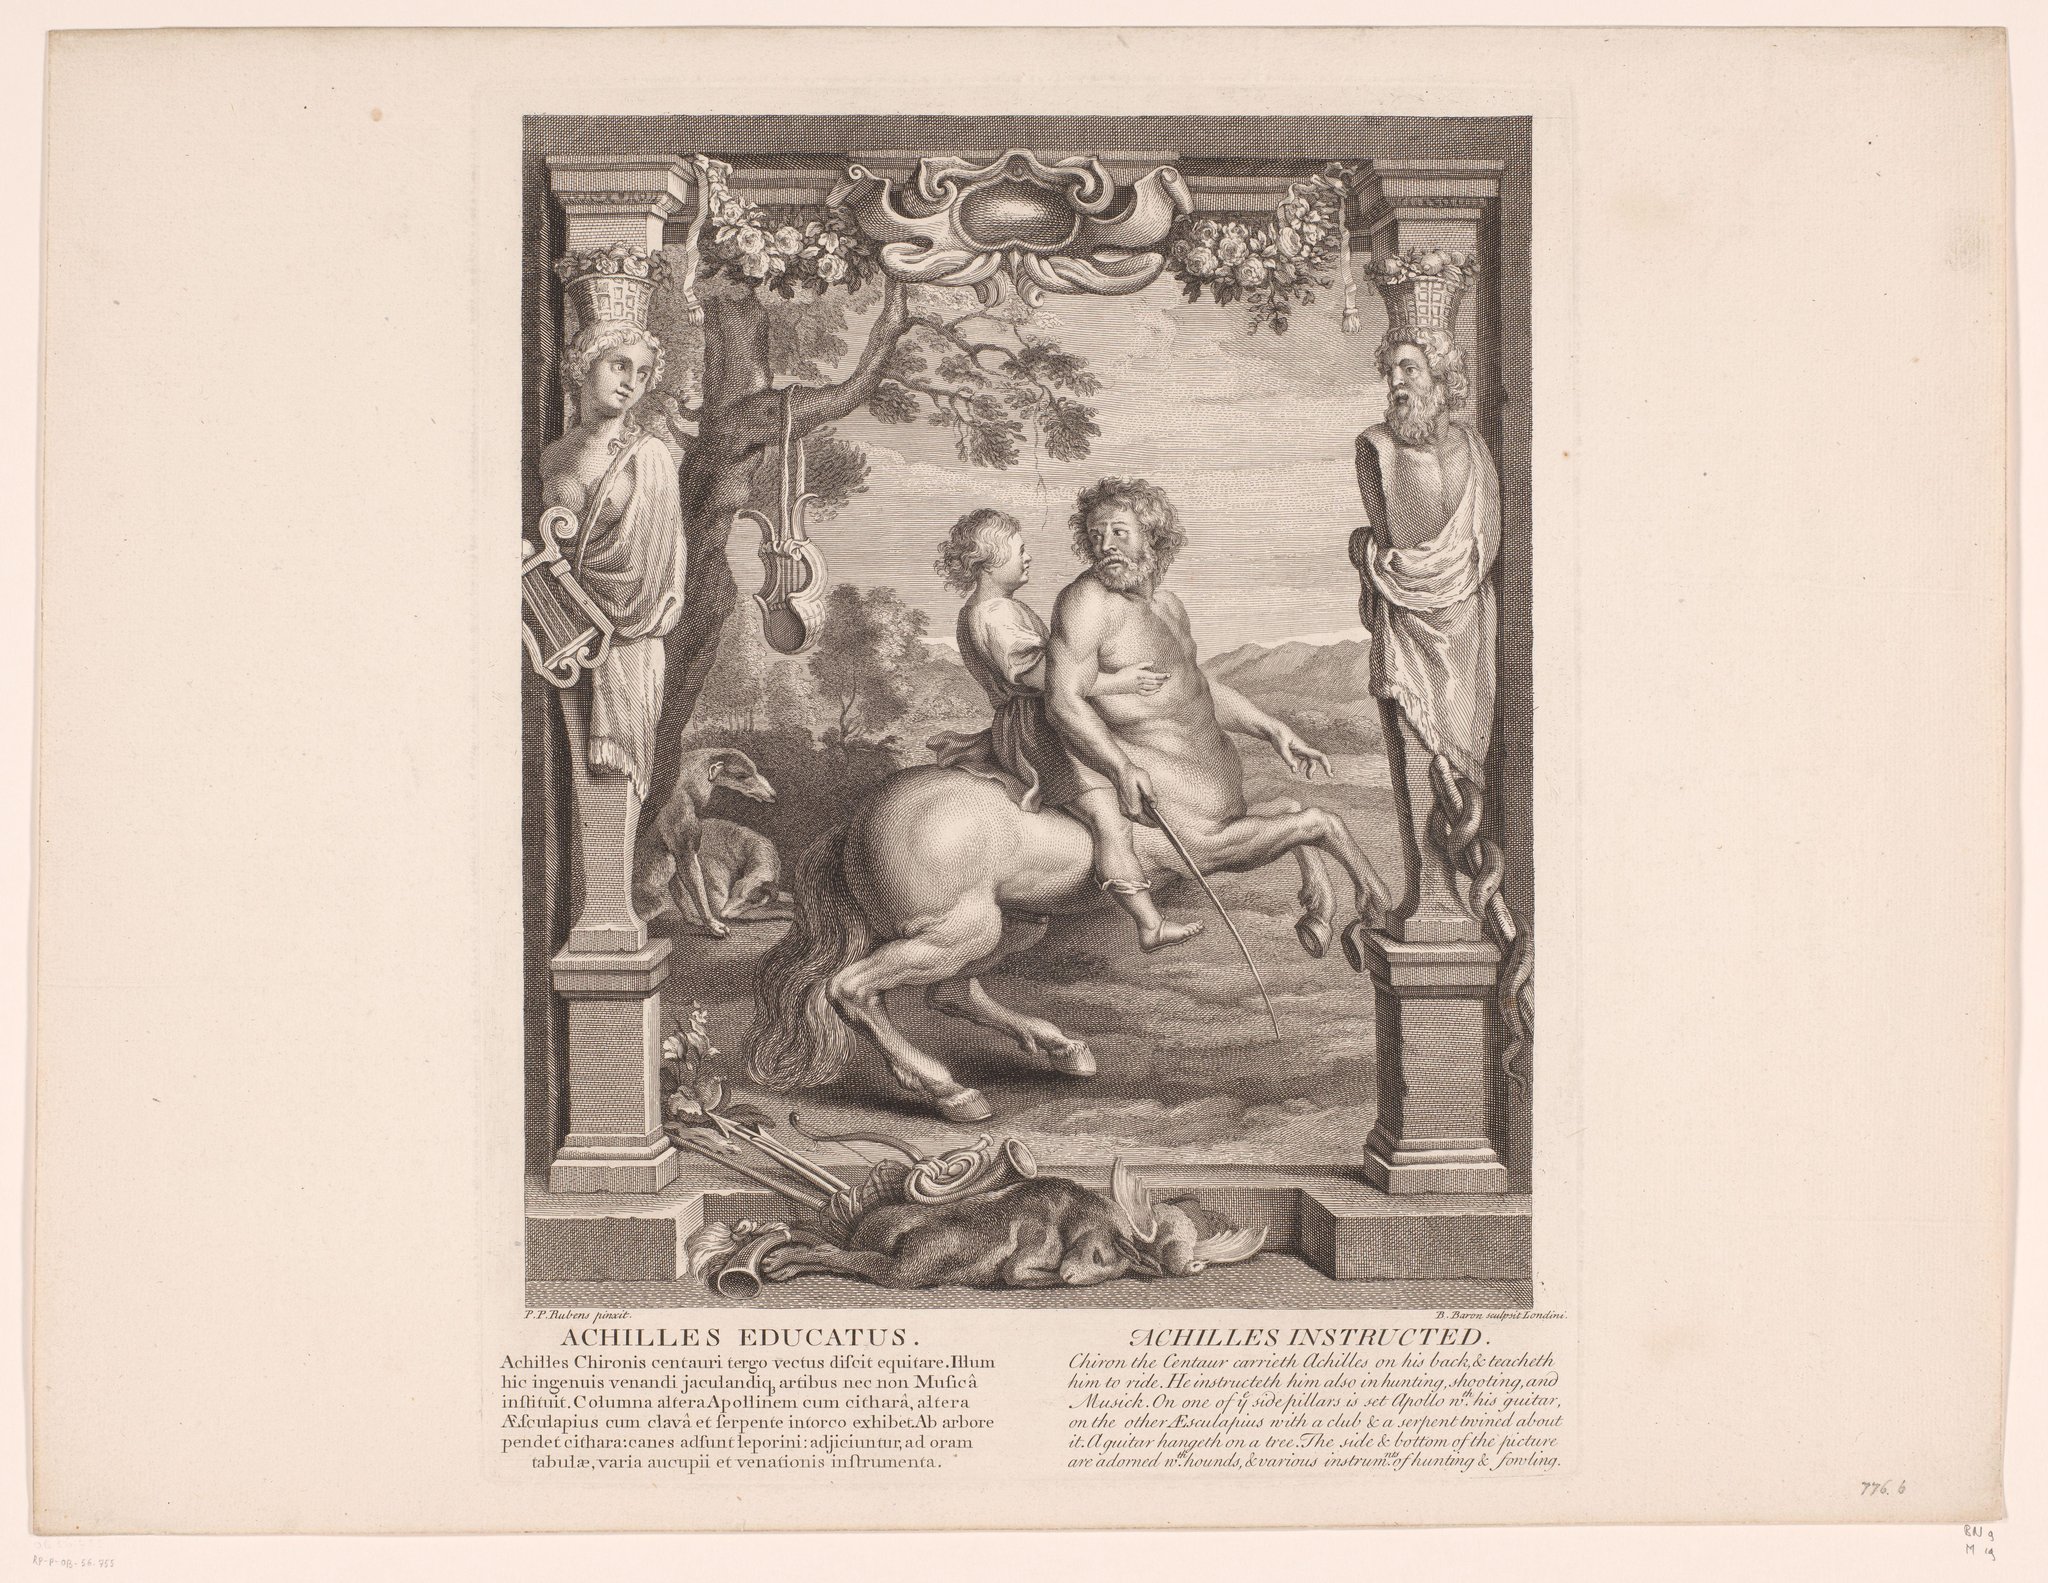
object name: print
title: Vie d'Achille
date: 1724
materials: paper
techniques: engraving, etching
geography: london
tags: the education of achilles by chiron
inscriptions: collector's mark: Lugt 240